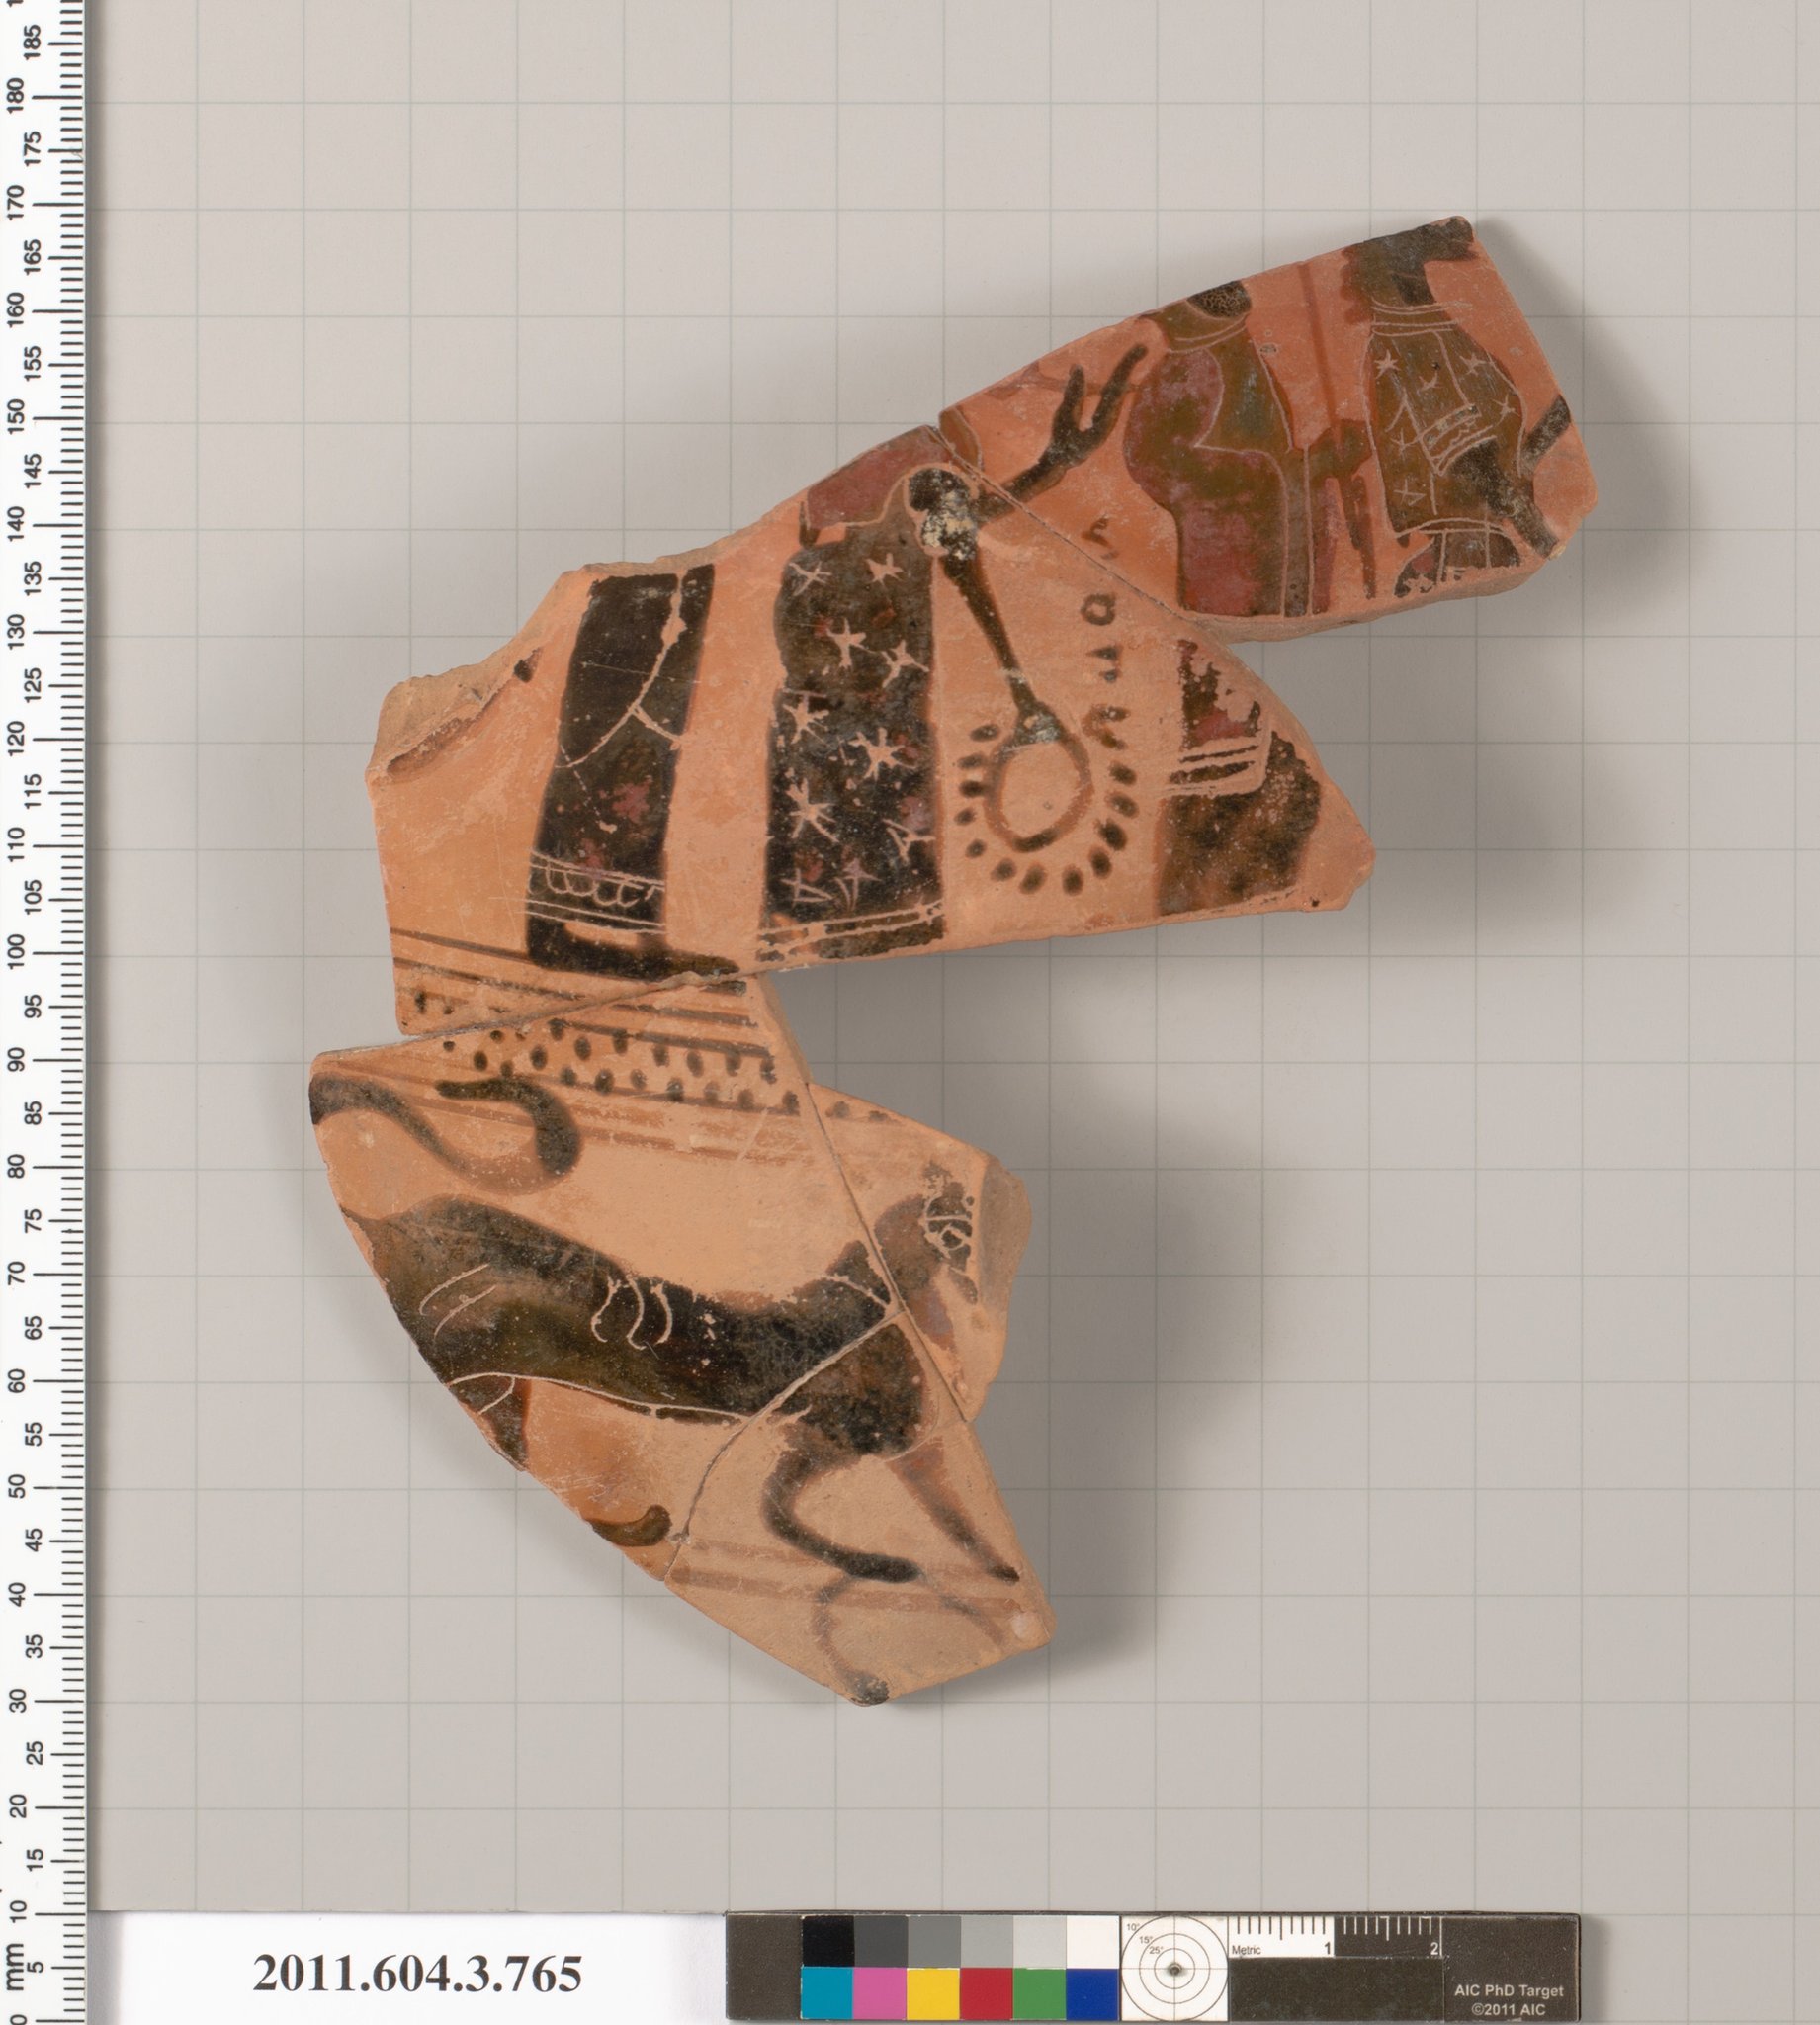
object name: neck amphora, tyrrhenian fragment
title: Terracotta fragment of a neck-amphora (jar)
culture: greek, attic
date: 575-551 BCE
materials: terracotta